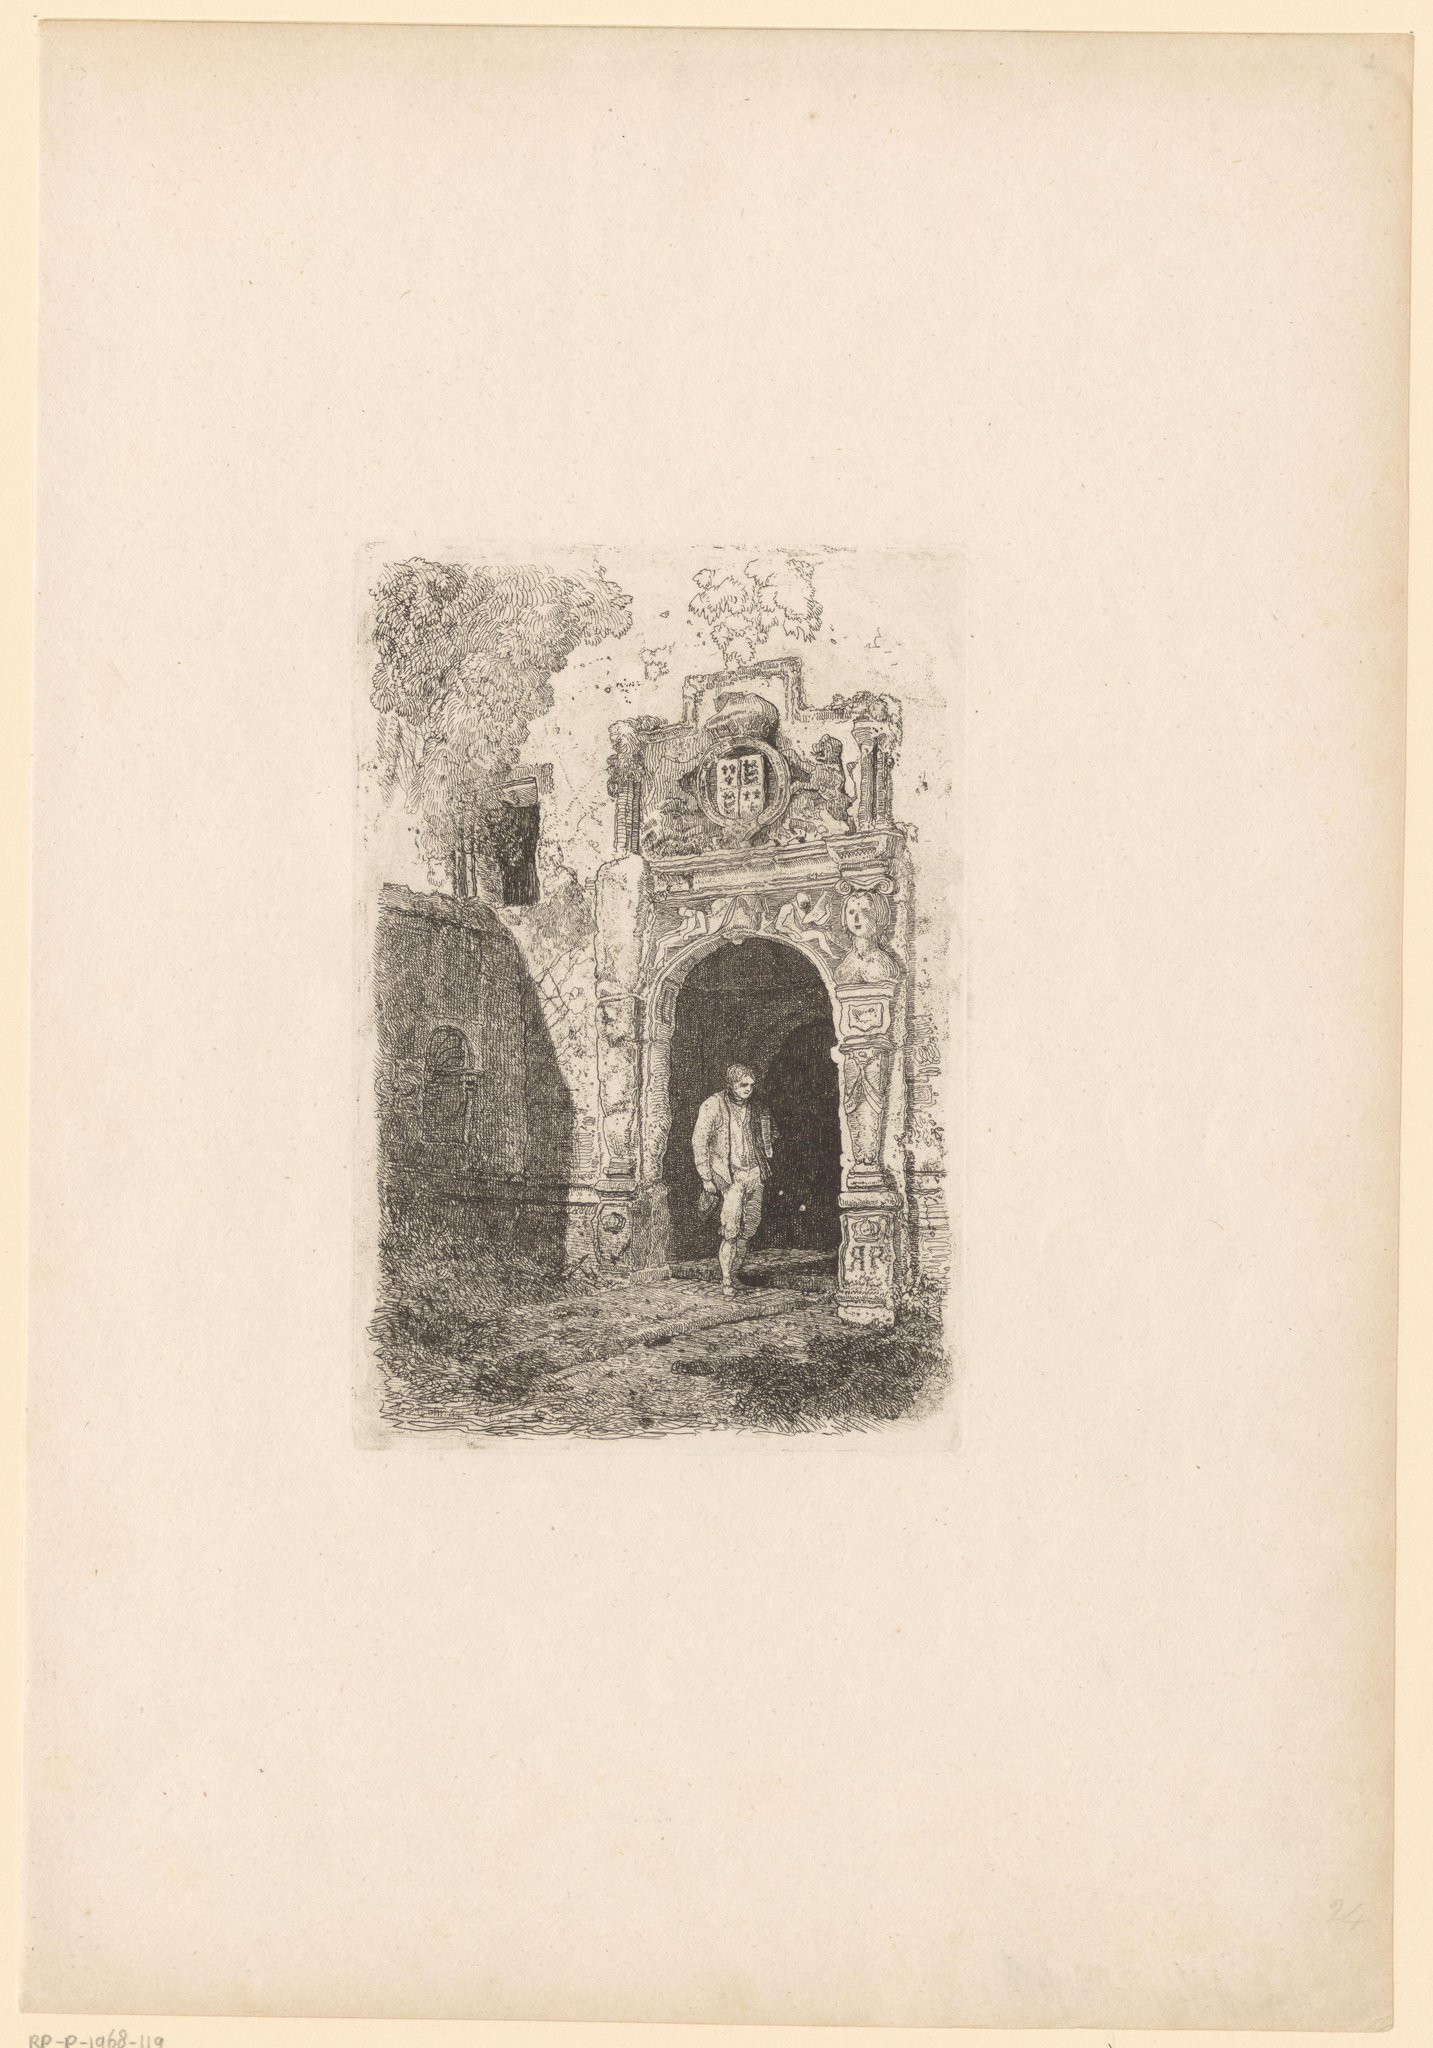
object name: print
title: Etsen door John Sell Cotman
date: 1810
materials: paper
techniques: etching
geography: london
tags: gate, entrance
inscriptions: collector's mark: Lugt 2228, collector's mark: Lugt 2760